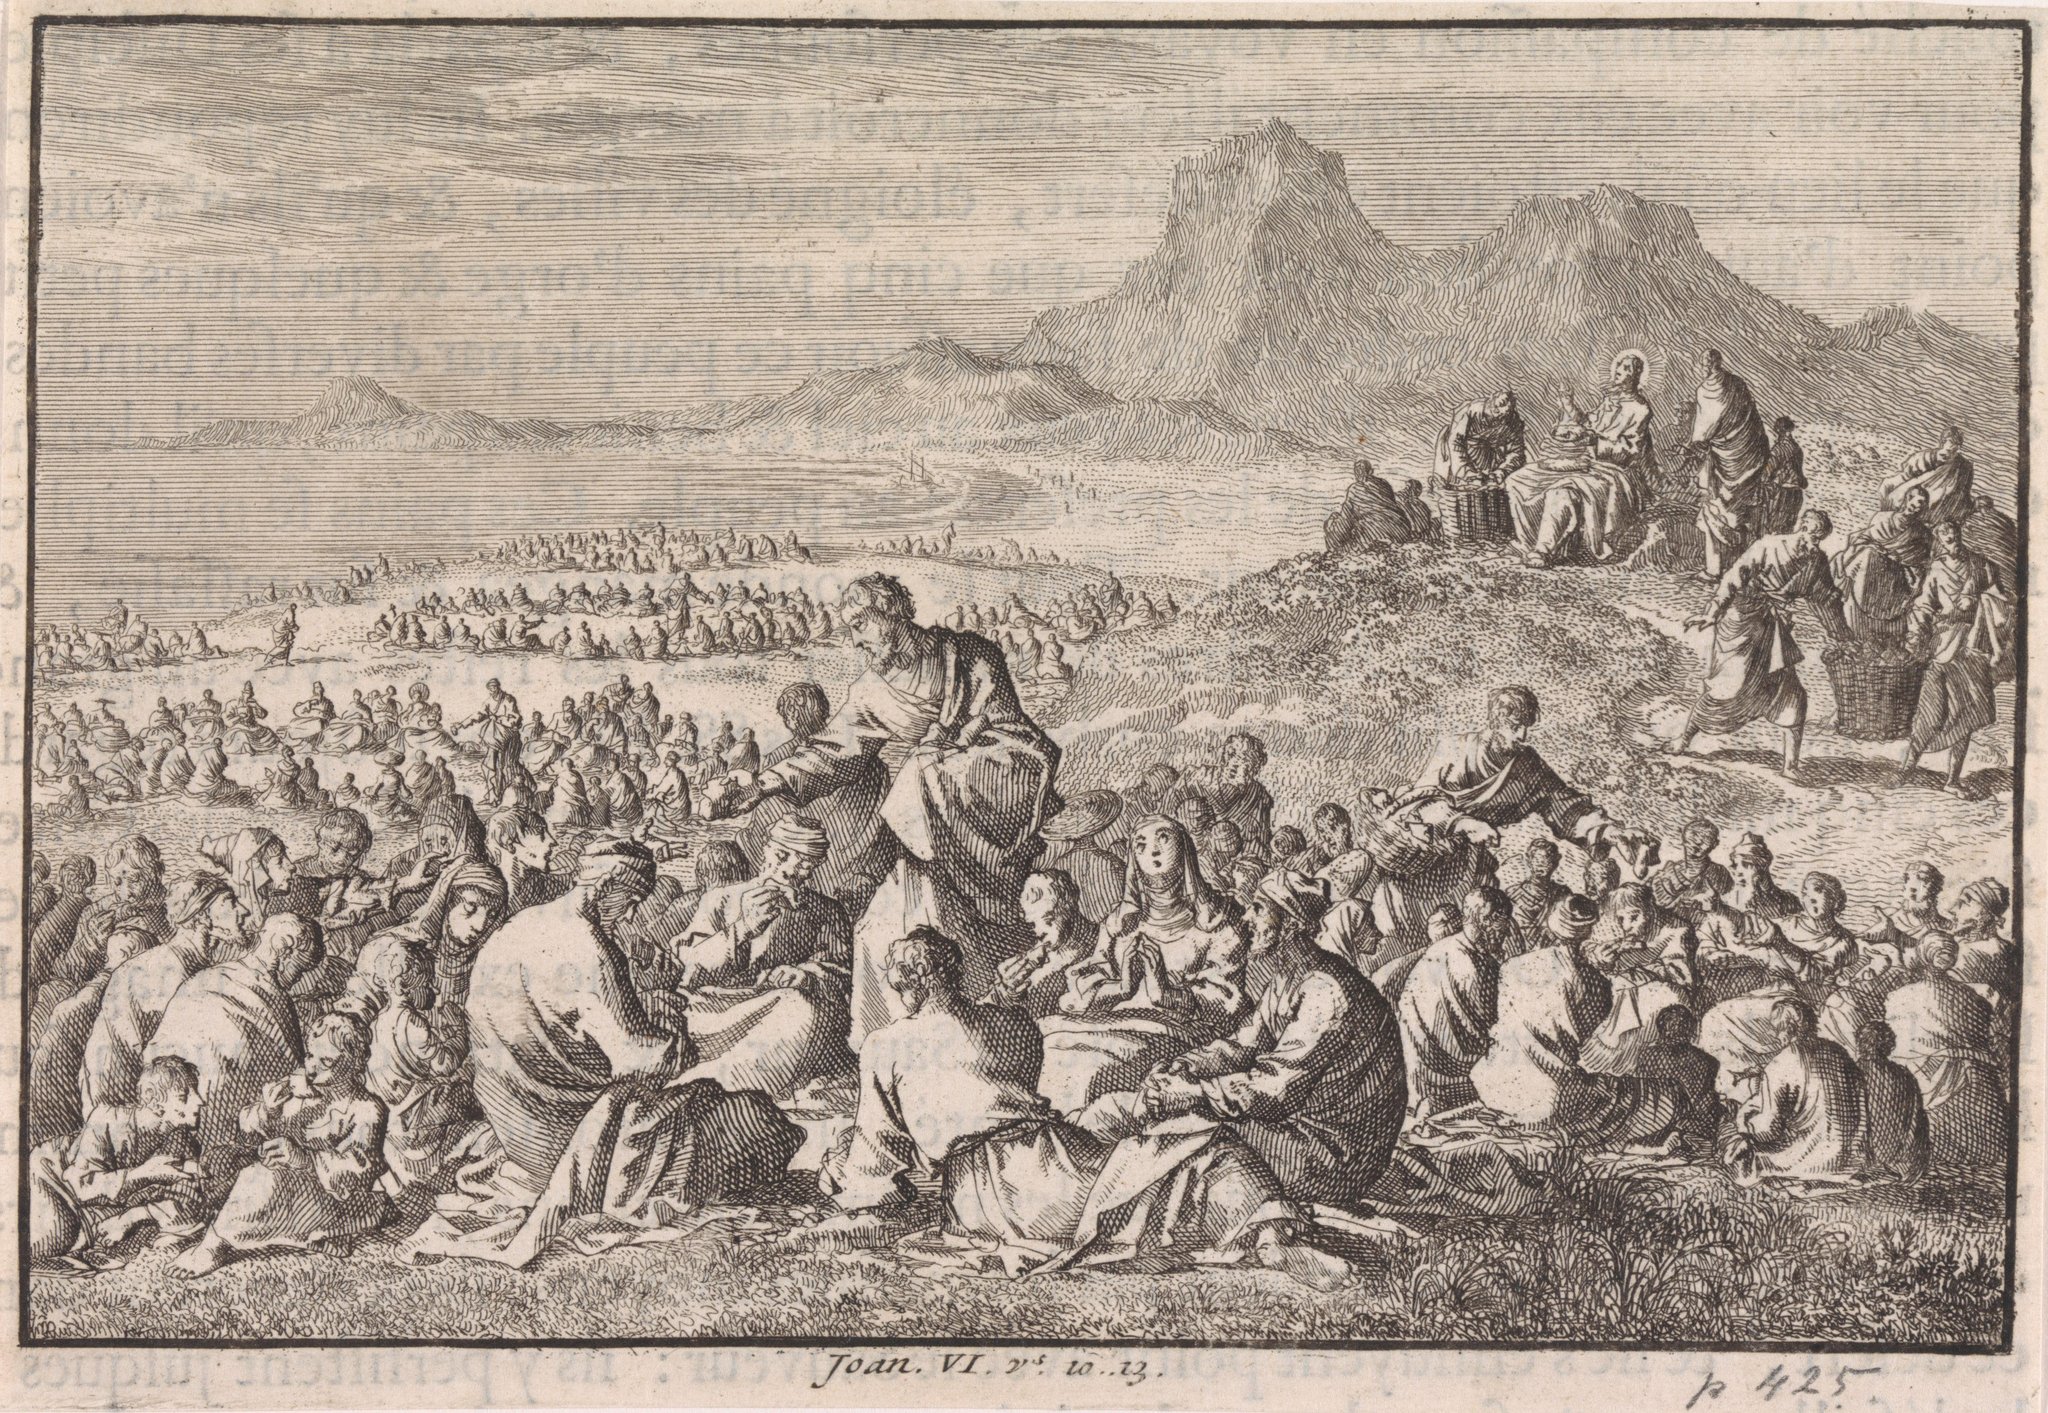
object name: book illustration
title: Wonderbaarlijke vermenigvuldiging van de zeven broden en de twee vissen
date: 1703-1762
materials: paper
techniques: etching, letterpress printing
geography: amsterdam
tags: multiplication of loaves and fishes for a multitude of four or five thousand people (matthew 14:13-21, 15:32-39; mark 6:32-44, 8:1-10; luke 9:10-17; john 6:1-14)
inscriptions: collector's mark: Lugt 2228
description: De prent komt een eerste keer voor als boekillustratie voor David Martin. Historie des Ouden en Nieuwen Testaments. Amsterdam, Pieter Mortier, 1703. Deel II. De boekillustraties voor de Mortierbijbel hebben verschillende staten en kopieën, waarbij de chronologische volgorde moeilijk te achterhalen valt. Als boekillustraties werden ze bovendien herhaaldelijk opnieuw gebruikt voor andere boekwerken.